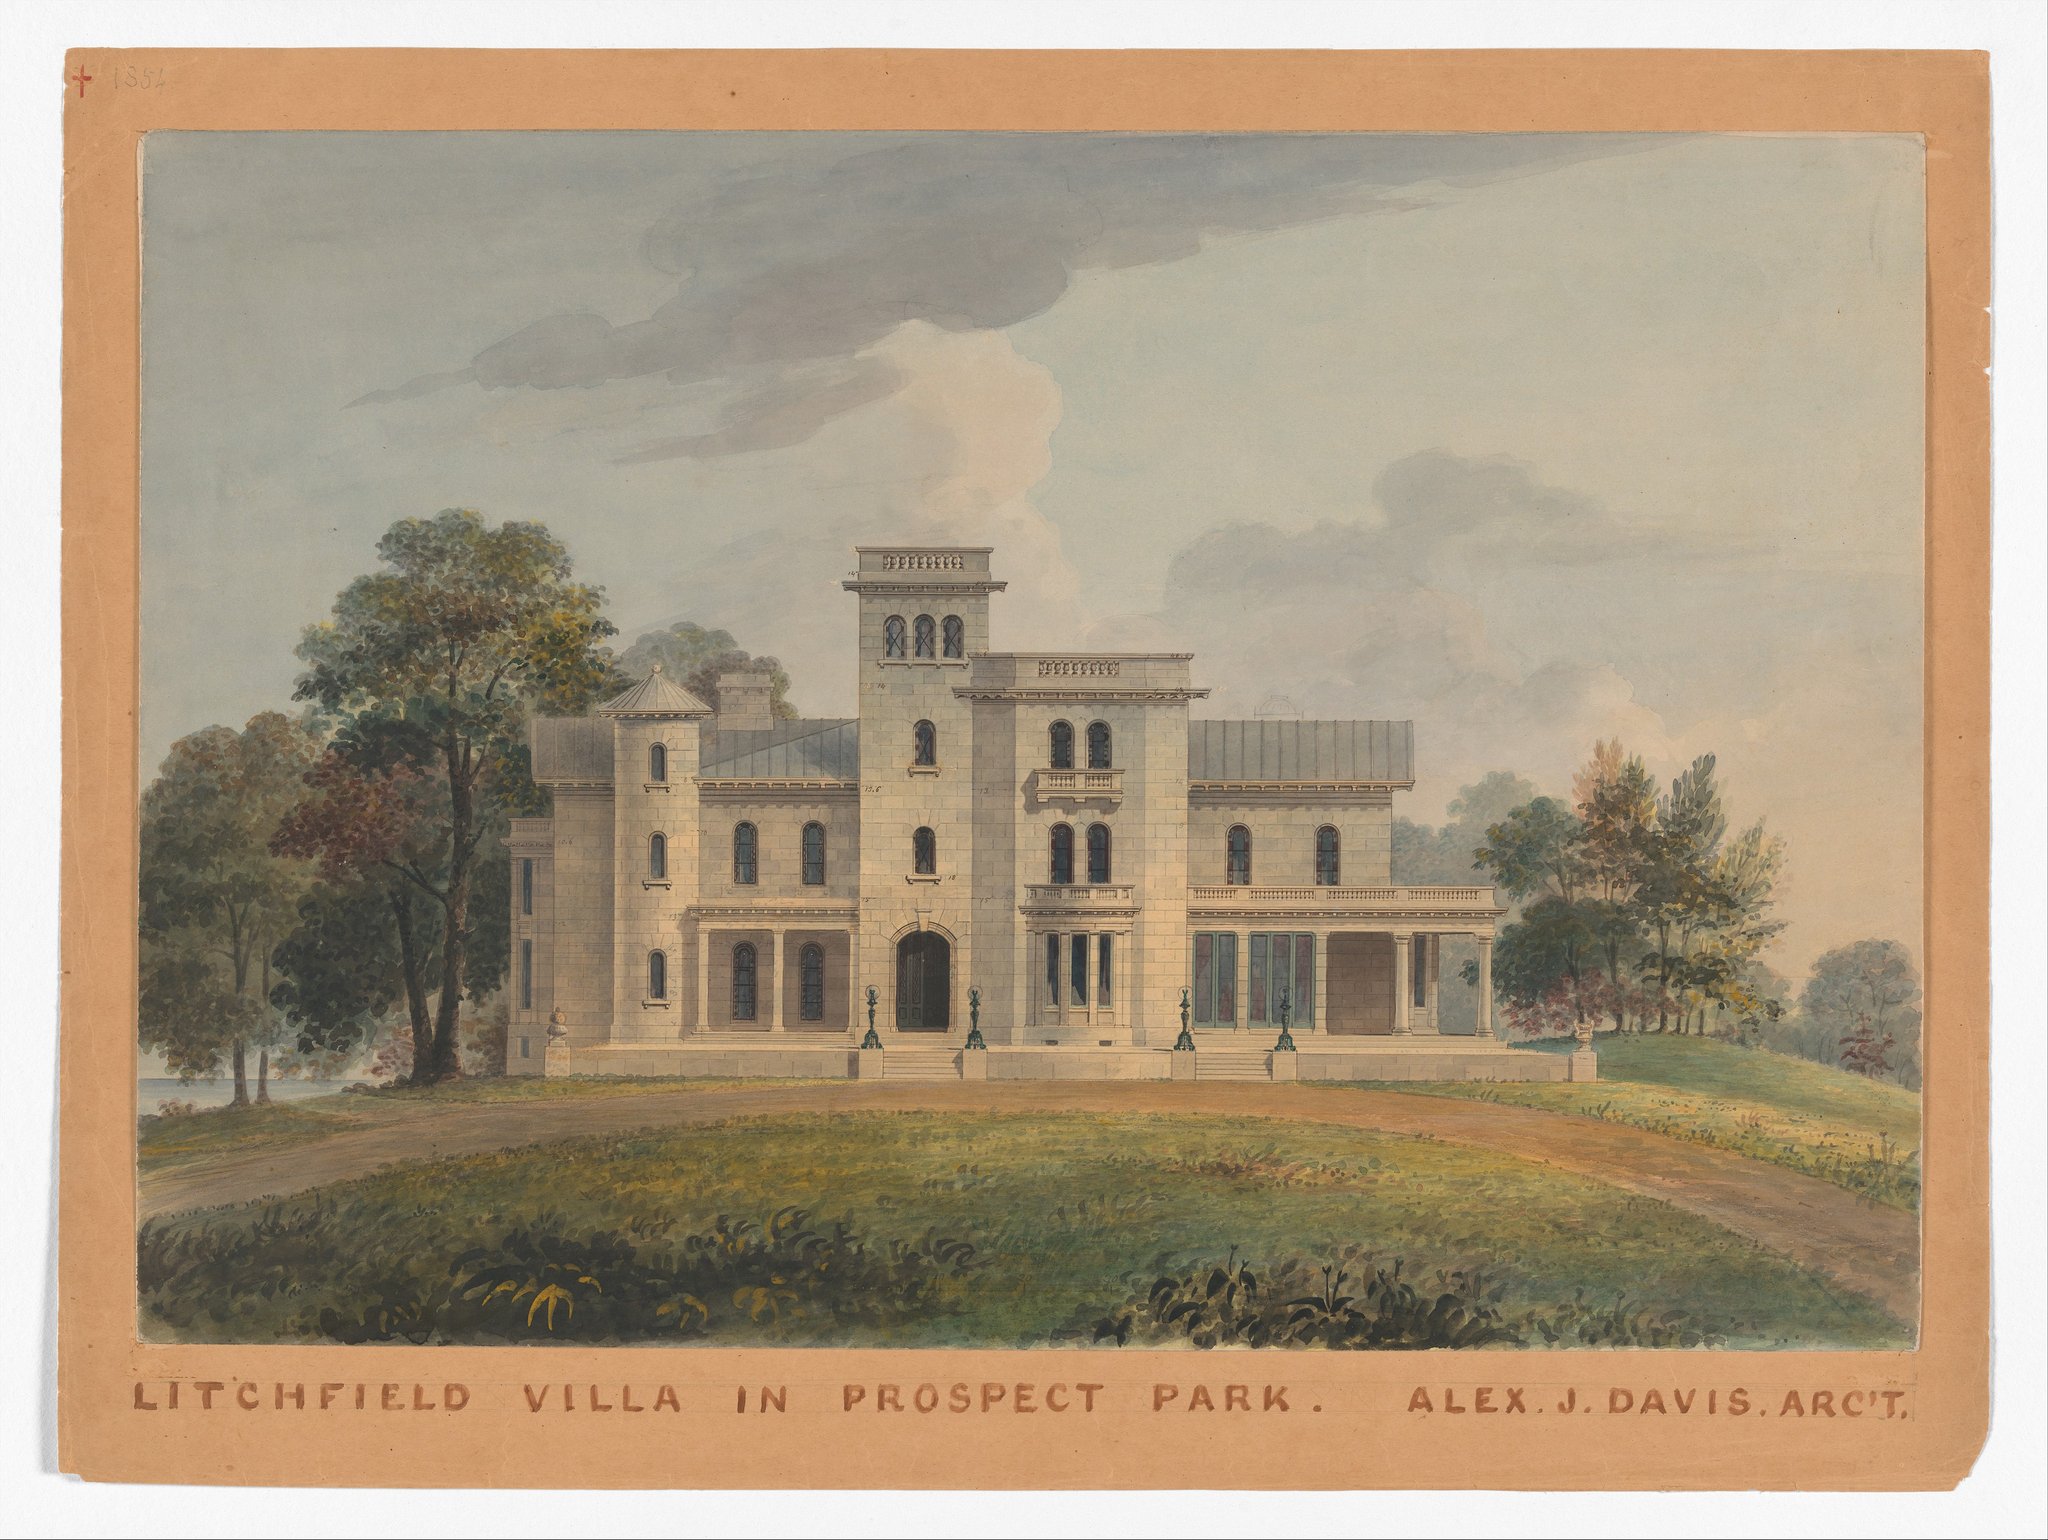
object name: drawing ornament architecture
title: Grace Hill for Edwin C. Litchfield, Brooklyn, New York (front elevation)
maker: alexander jackson davis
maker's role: artist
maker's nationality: american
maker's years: 1803-1892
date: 1854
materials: graphite, ink, paper, watercolor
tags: architecture,houses